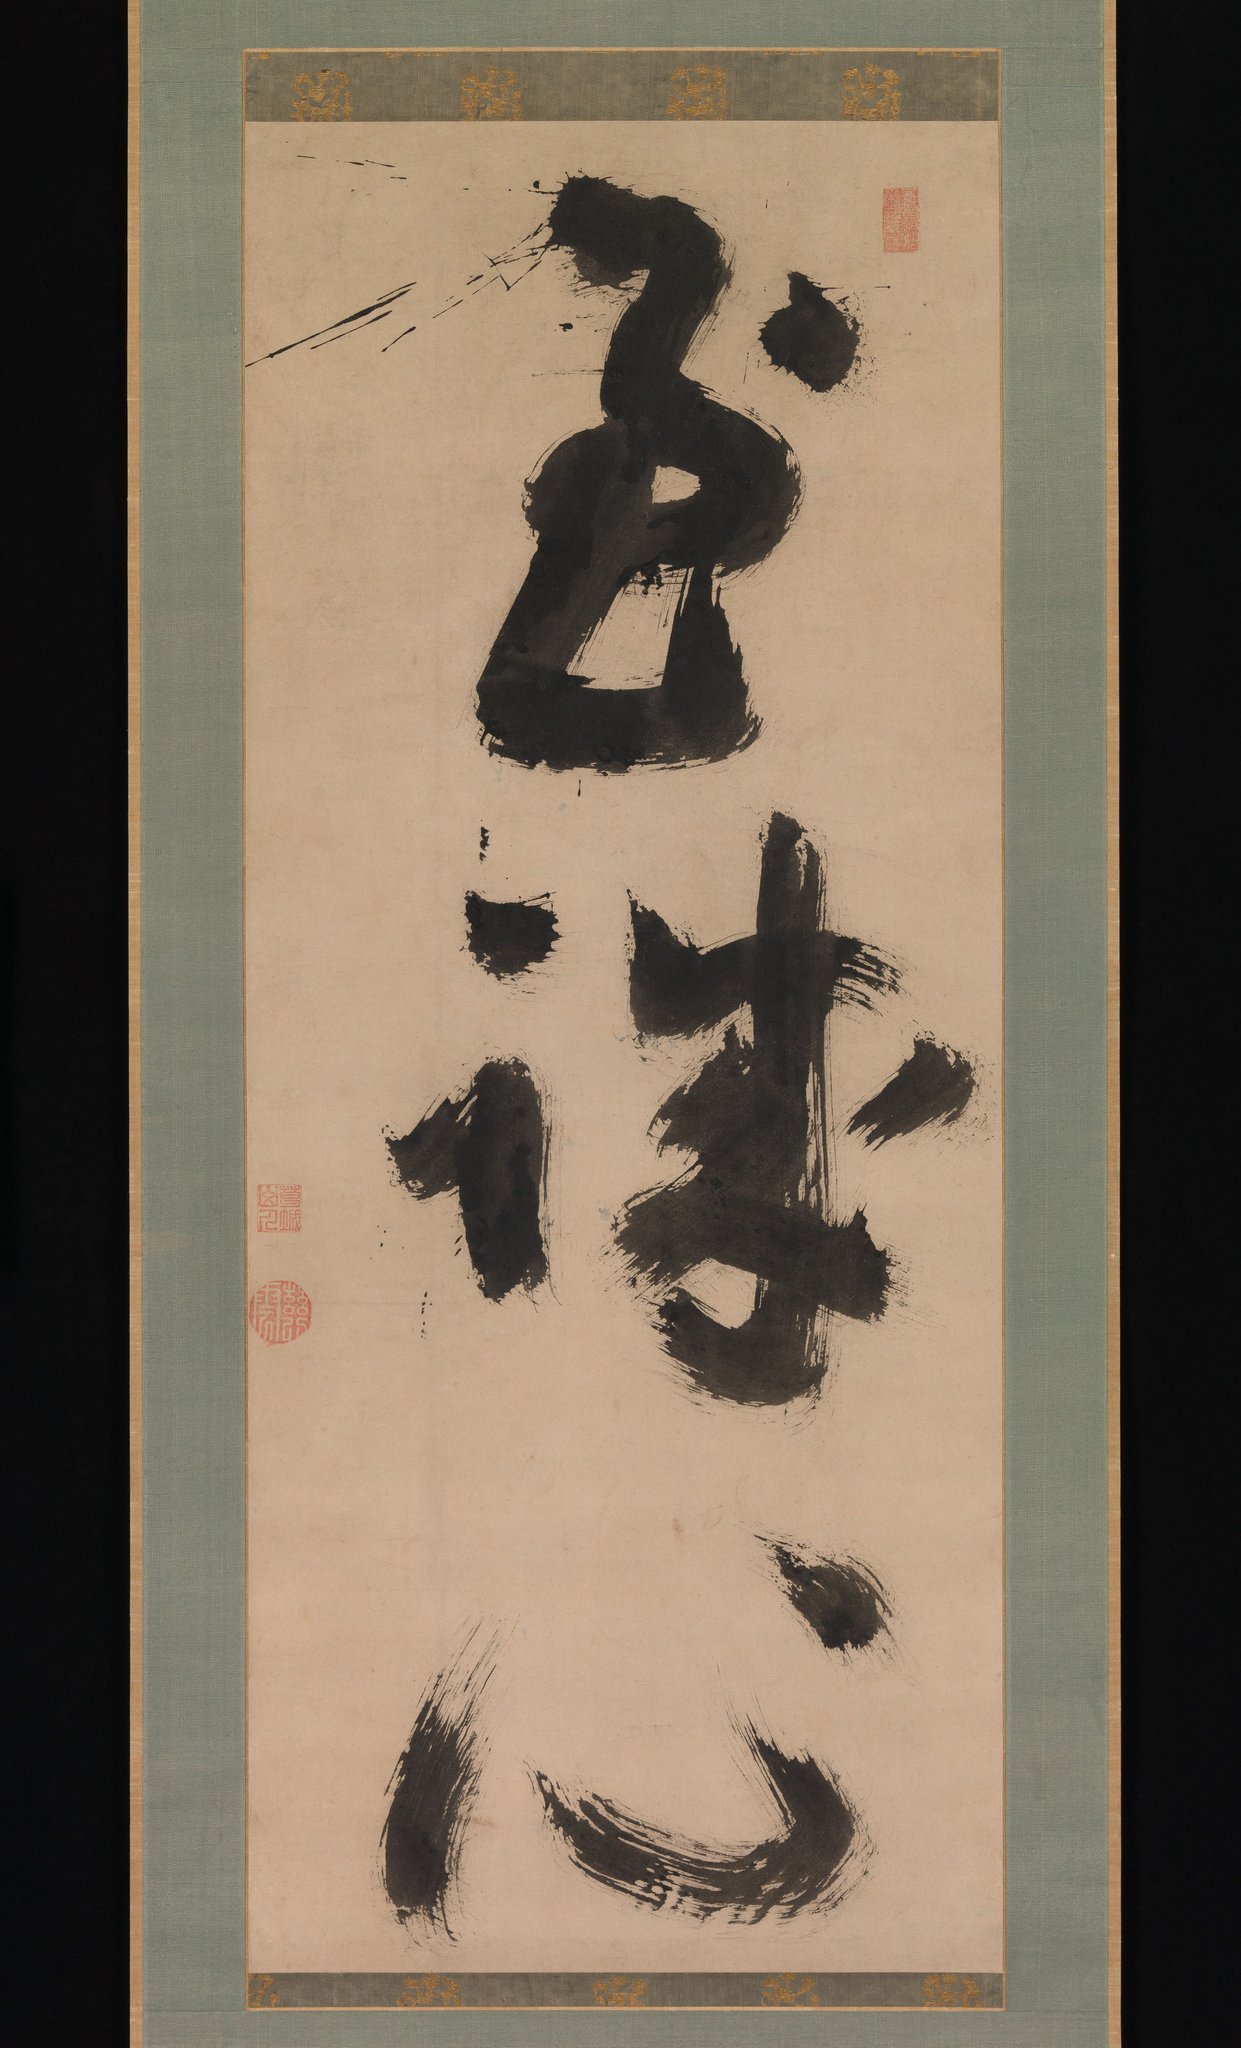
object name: hanging scroll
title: "Profound Sincerity"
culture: japanese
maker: jiun onkō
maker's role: artist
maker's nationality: japanese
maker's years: 1718-1804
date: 1780-1790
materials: ink, paper